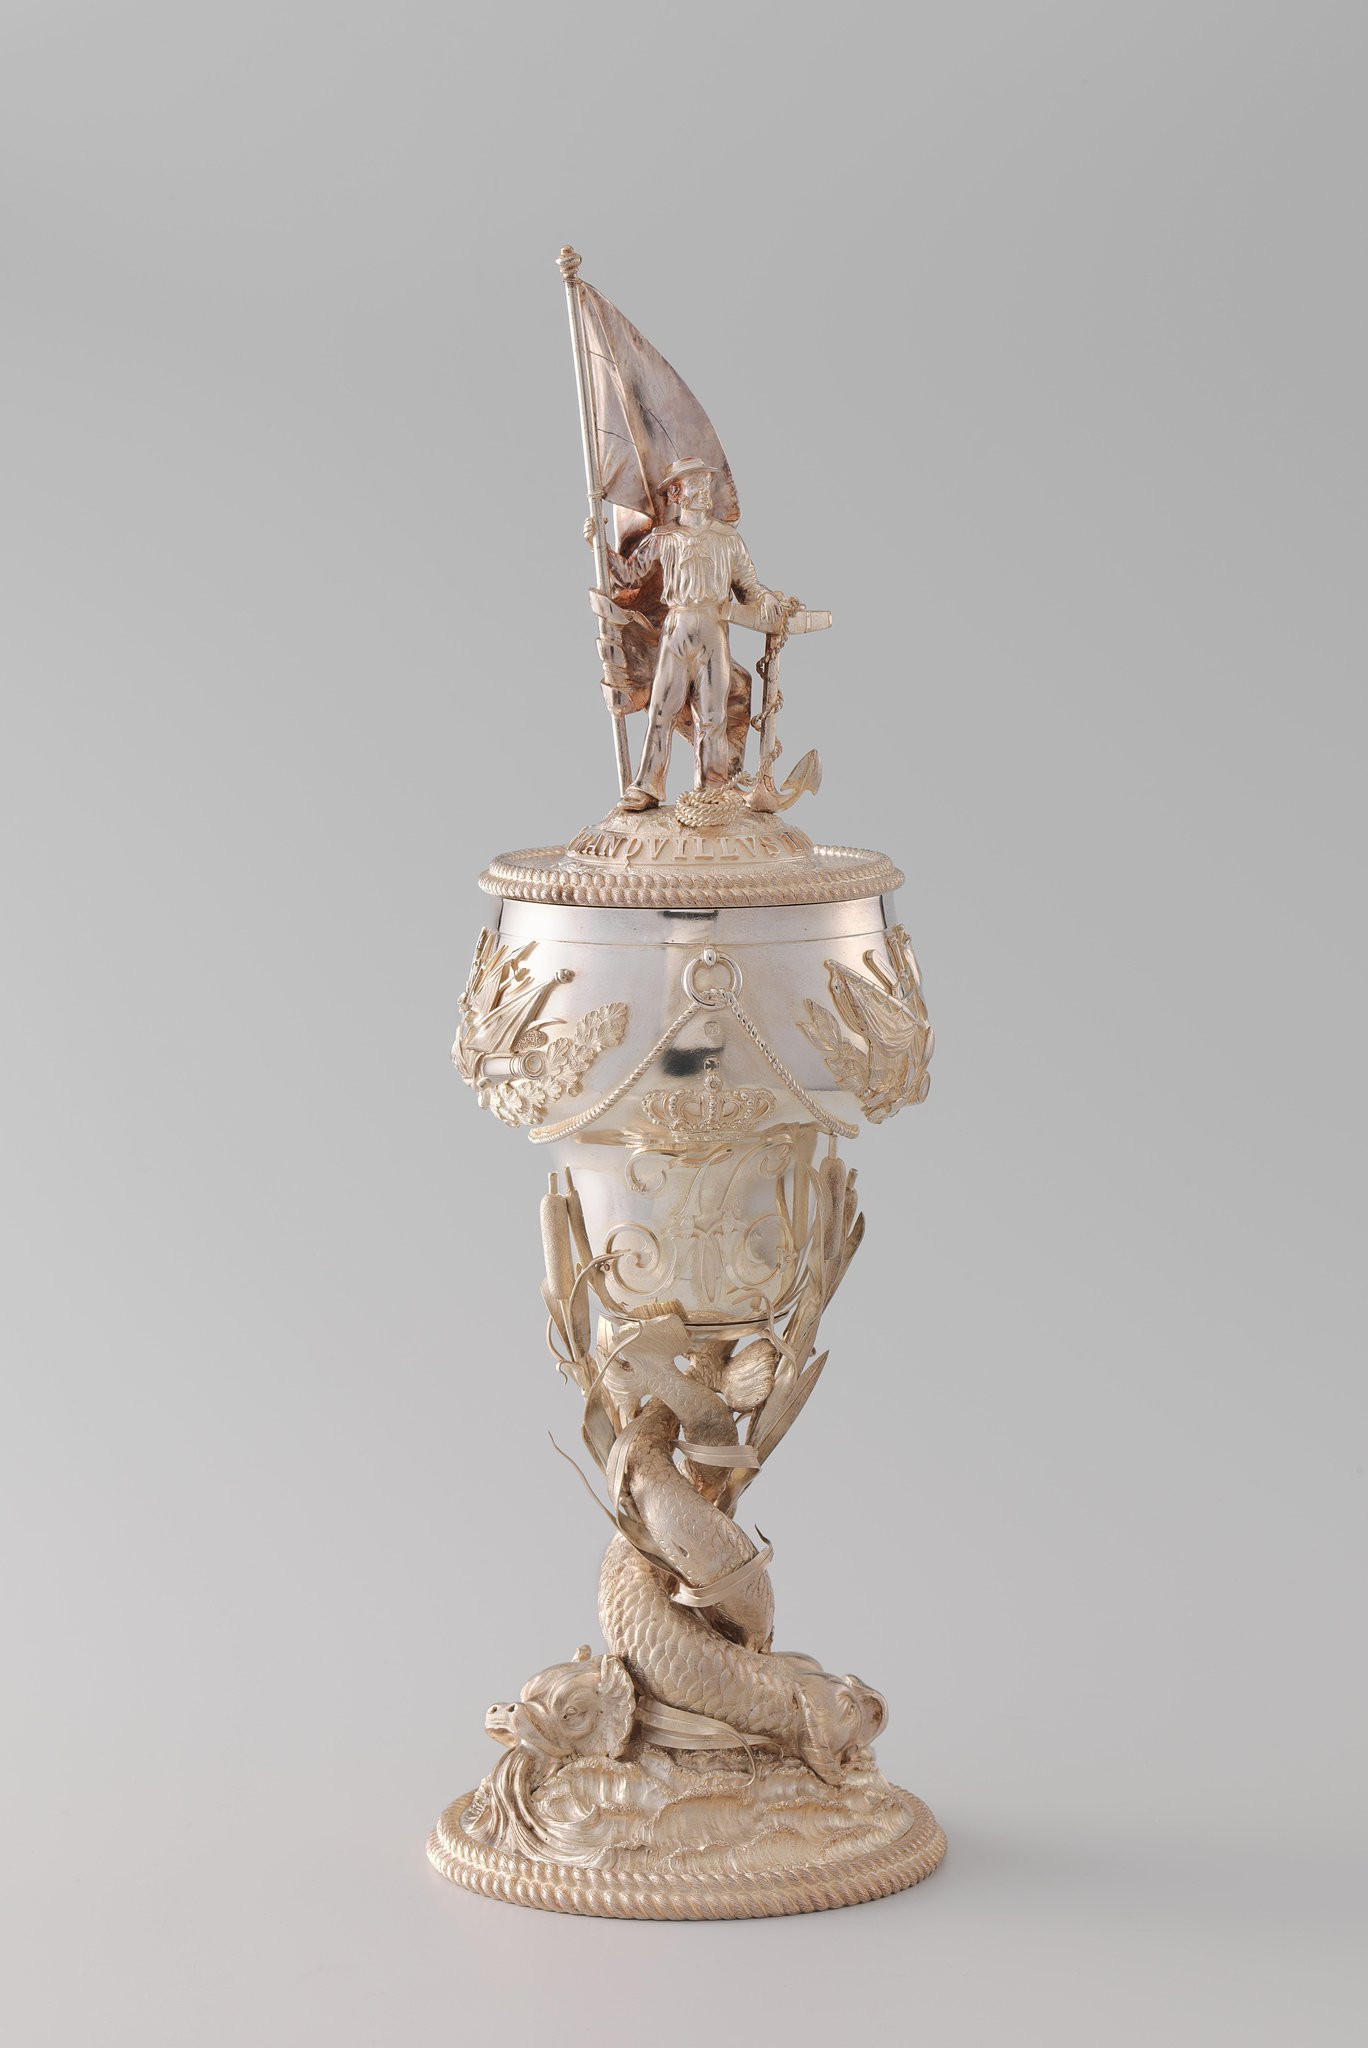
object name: lid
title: Silver Birthday Cup for Lieutenant Admiral Engelbert Lucas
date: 1865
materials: silver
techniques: casting, gilding, riveted, screwed, soldering, striking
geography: voorschoten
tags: the hague, engelbertus lucas, hendrik (prins der nederlanden)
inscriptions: date letter: ‘F’, maker's mark, maker's mark, alloy mark, retailer's mark: ‘VAN KEMPEN / HOFLEVERANCIER’, inscription: ‘SAEVIS TRANQVILLVS IN VNDIS.’, hallmark, inscription: ‘Aan / DEN LUITENANT- / ADMIRAAL / E. LUCAS / Bij het vieren / van zijnen 80sten geboortedag / en als hulde / voor meer dan 70 jaren getrouwe dienst / door hem aan den Lande bewezen / aangeboden / door Z.K.H. PRINS Hendrik / der Nederlanden / LUITENANT ADMIRAAL / Opperbevelheber der vloot / den 30 mei 1865.’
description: E. Lucas (1785-1870) volgde een lange carrière bij de Marine en was minister van Marine in 1849-1850. Deze beker werd hem aangeboden door prins Hendrik ter ere van zijn 80ste geboortedag en meer dan 70 jaren trouwe dienst.